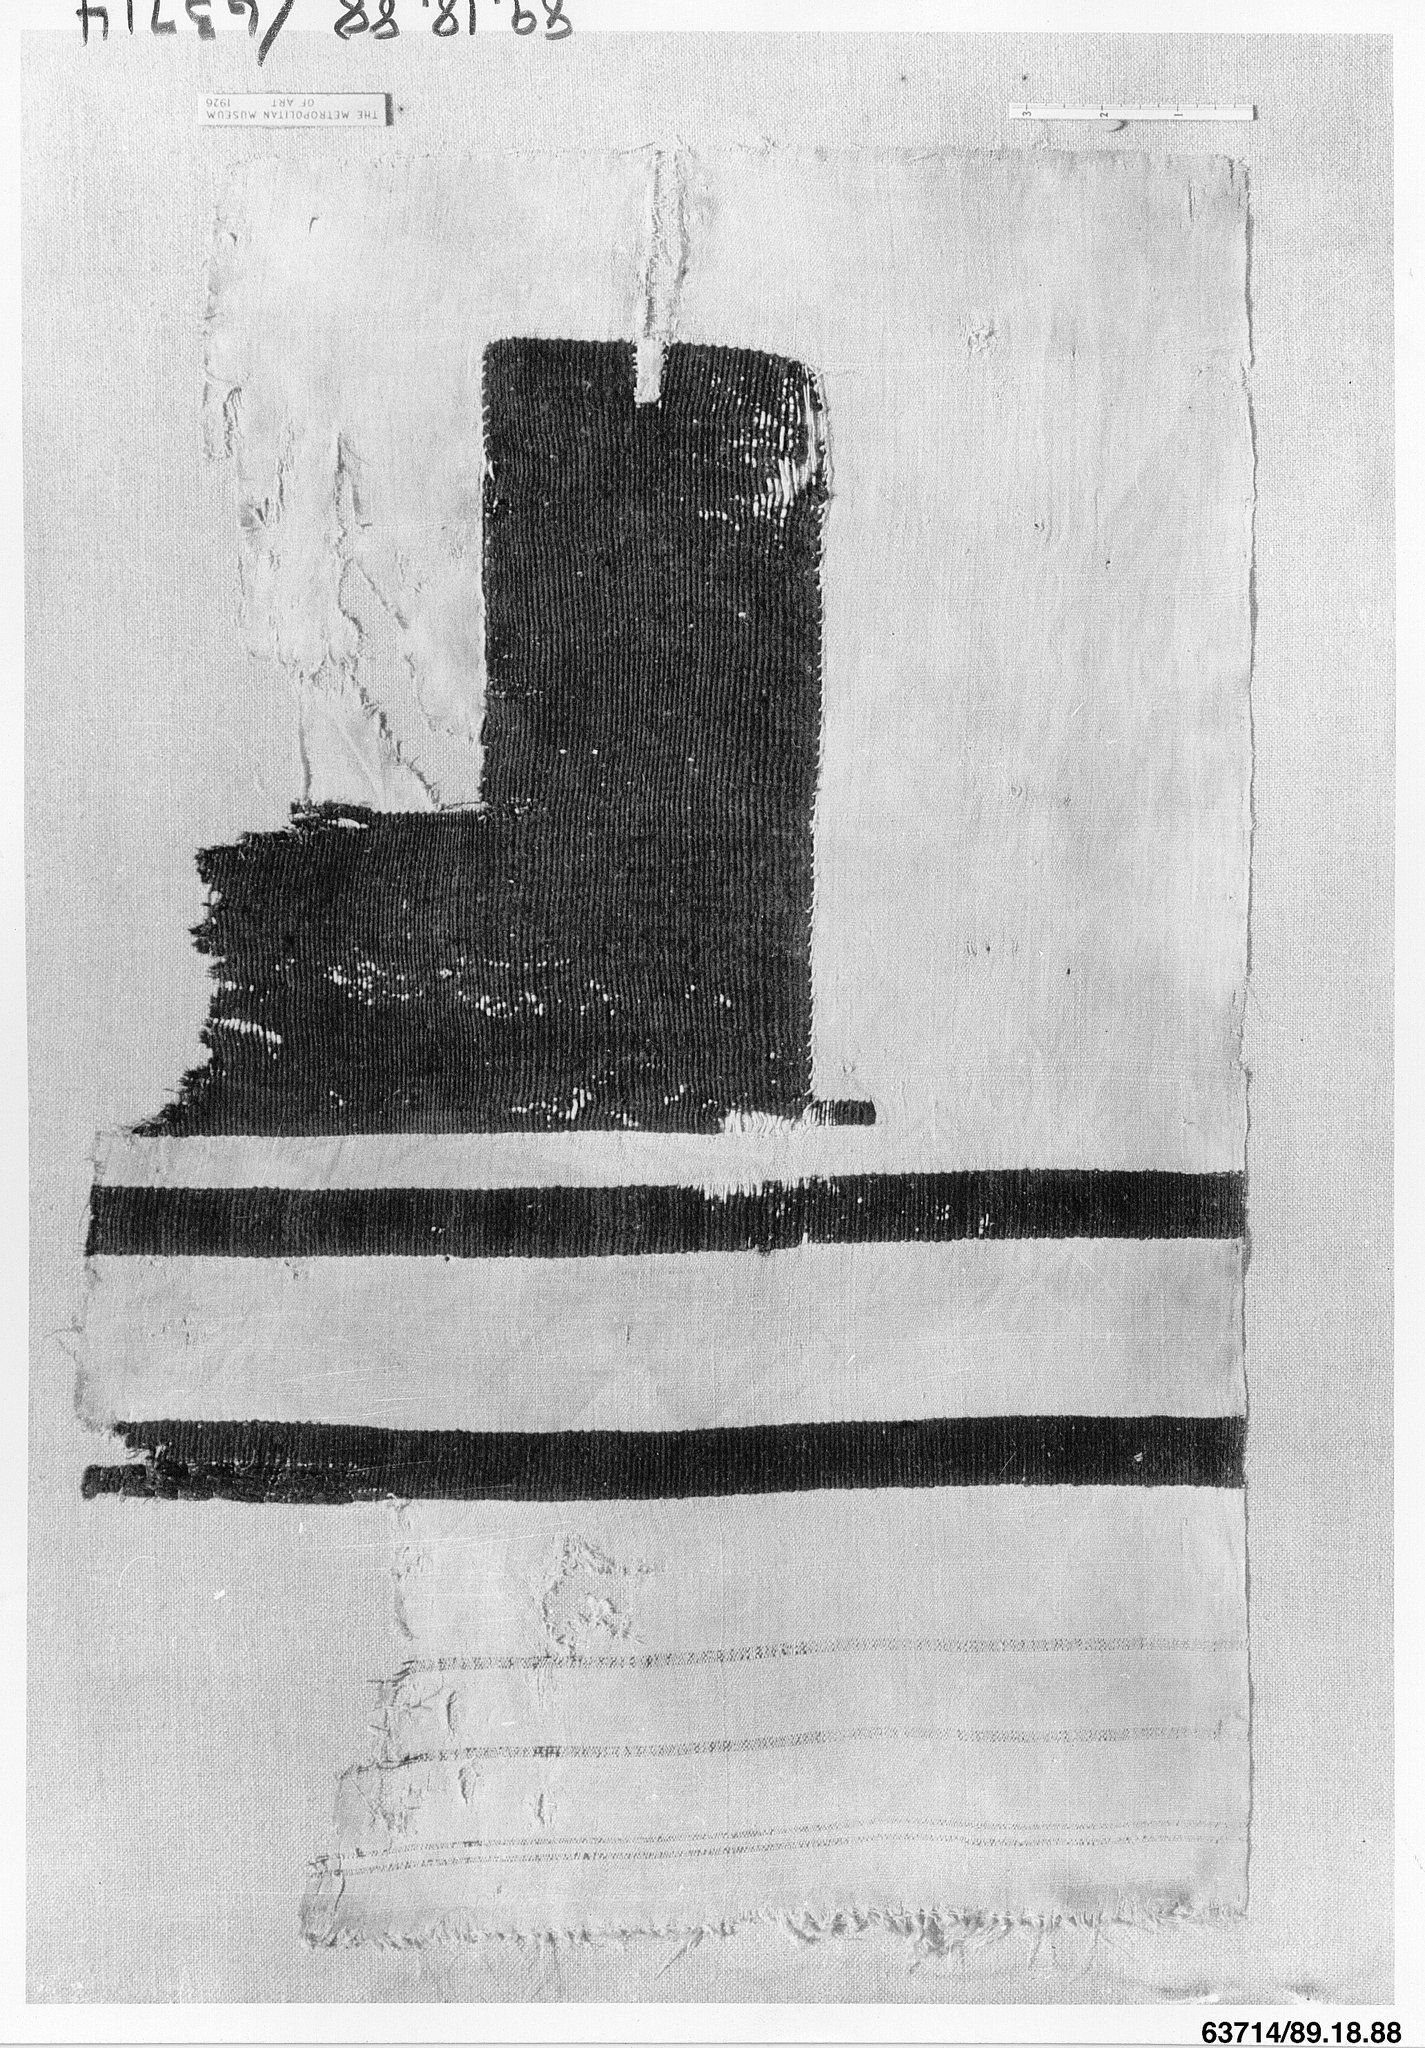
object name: textile fragment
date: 201-400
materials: linen, wool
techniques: weave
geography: egypt